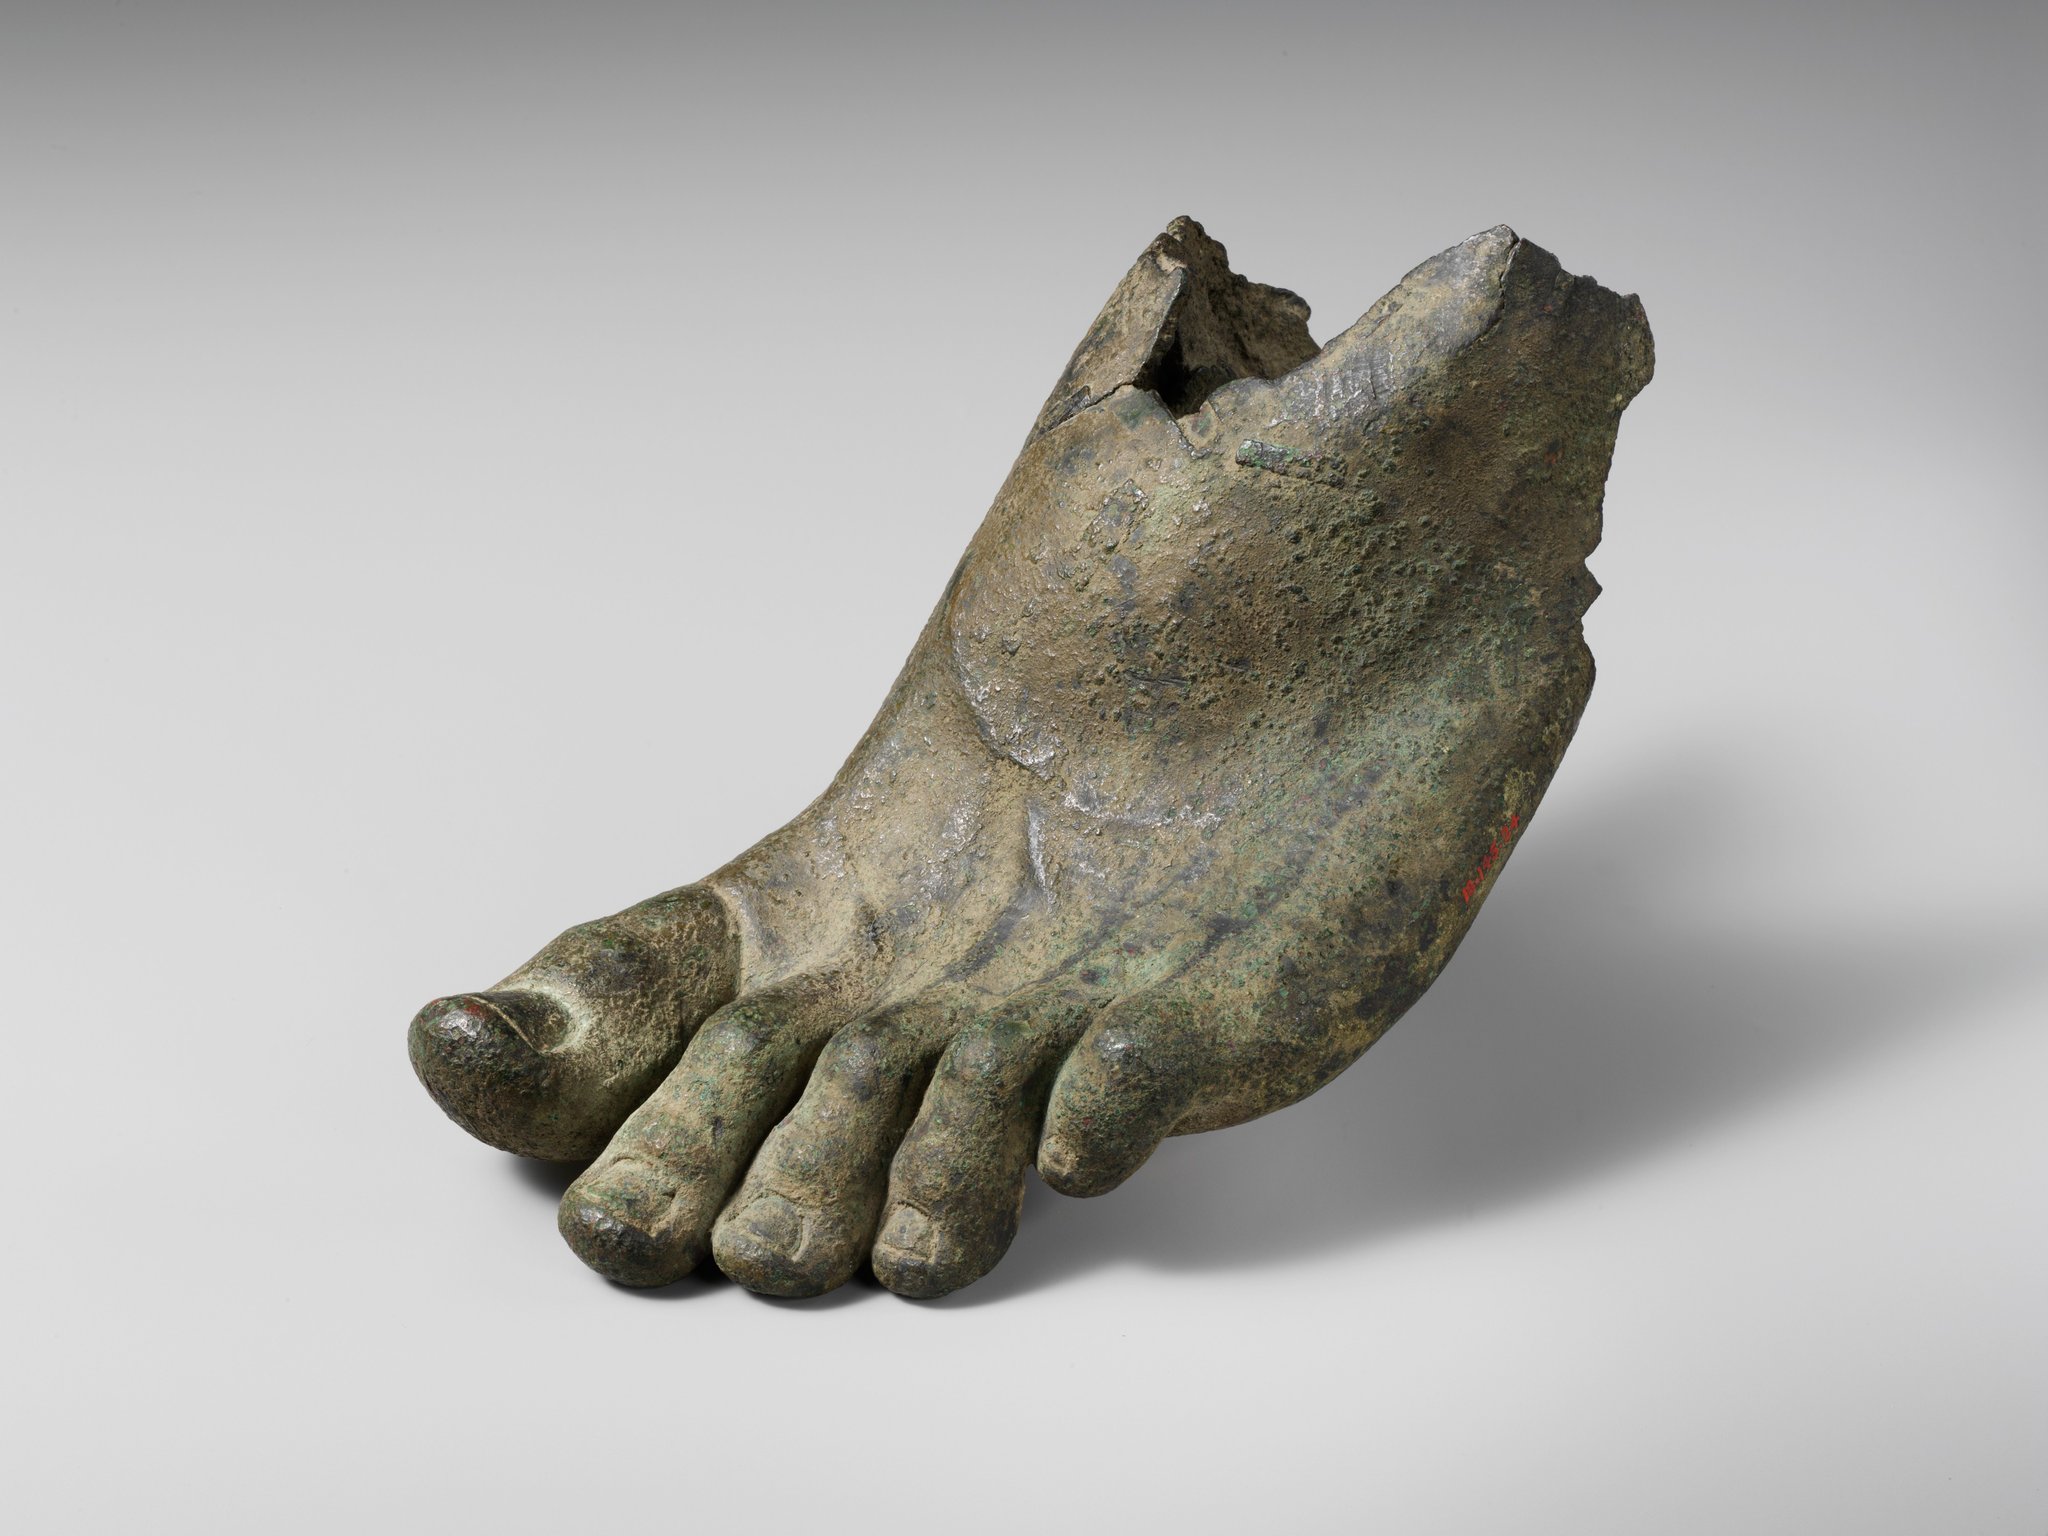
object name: foot fragment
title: Bronze left foot with traces of sandal straps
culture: roman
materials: bronze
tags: feet